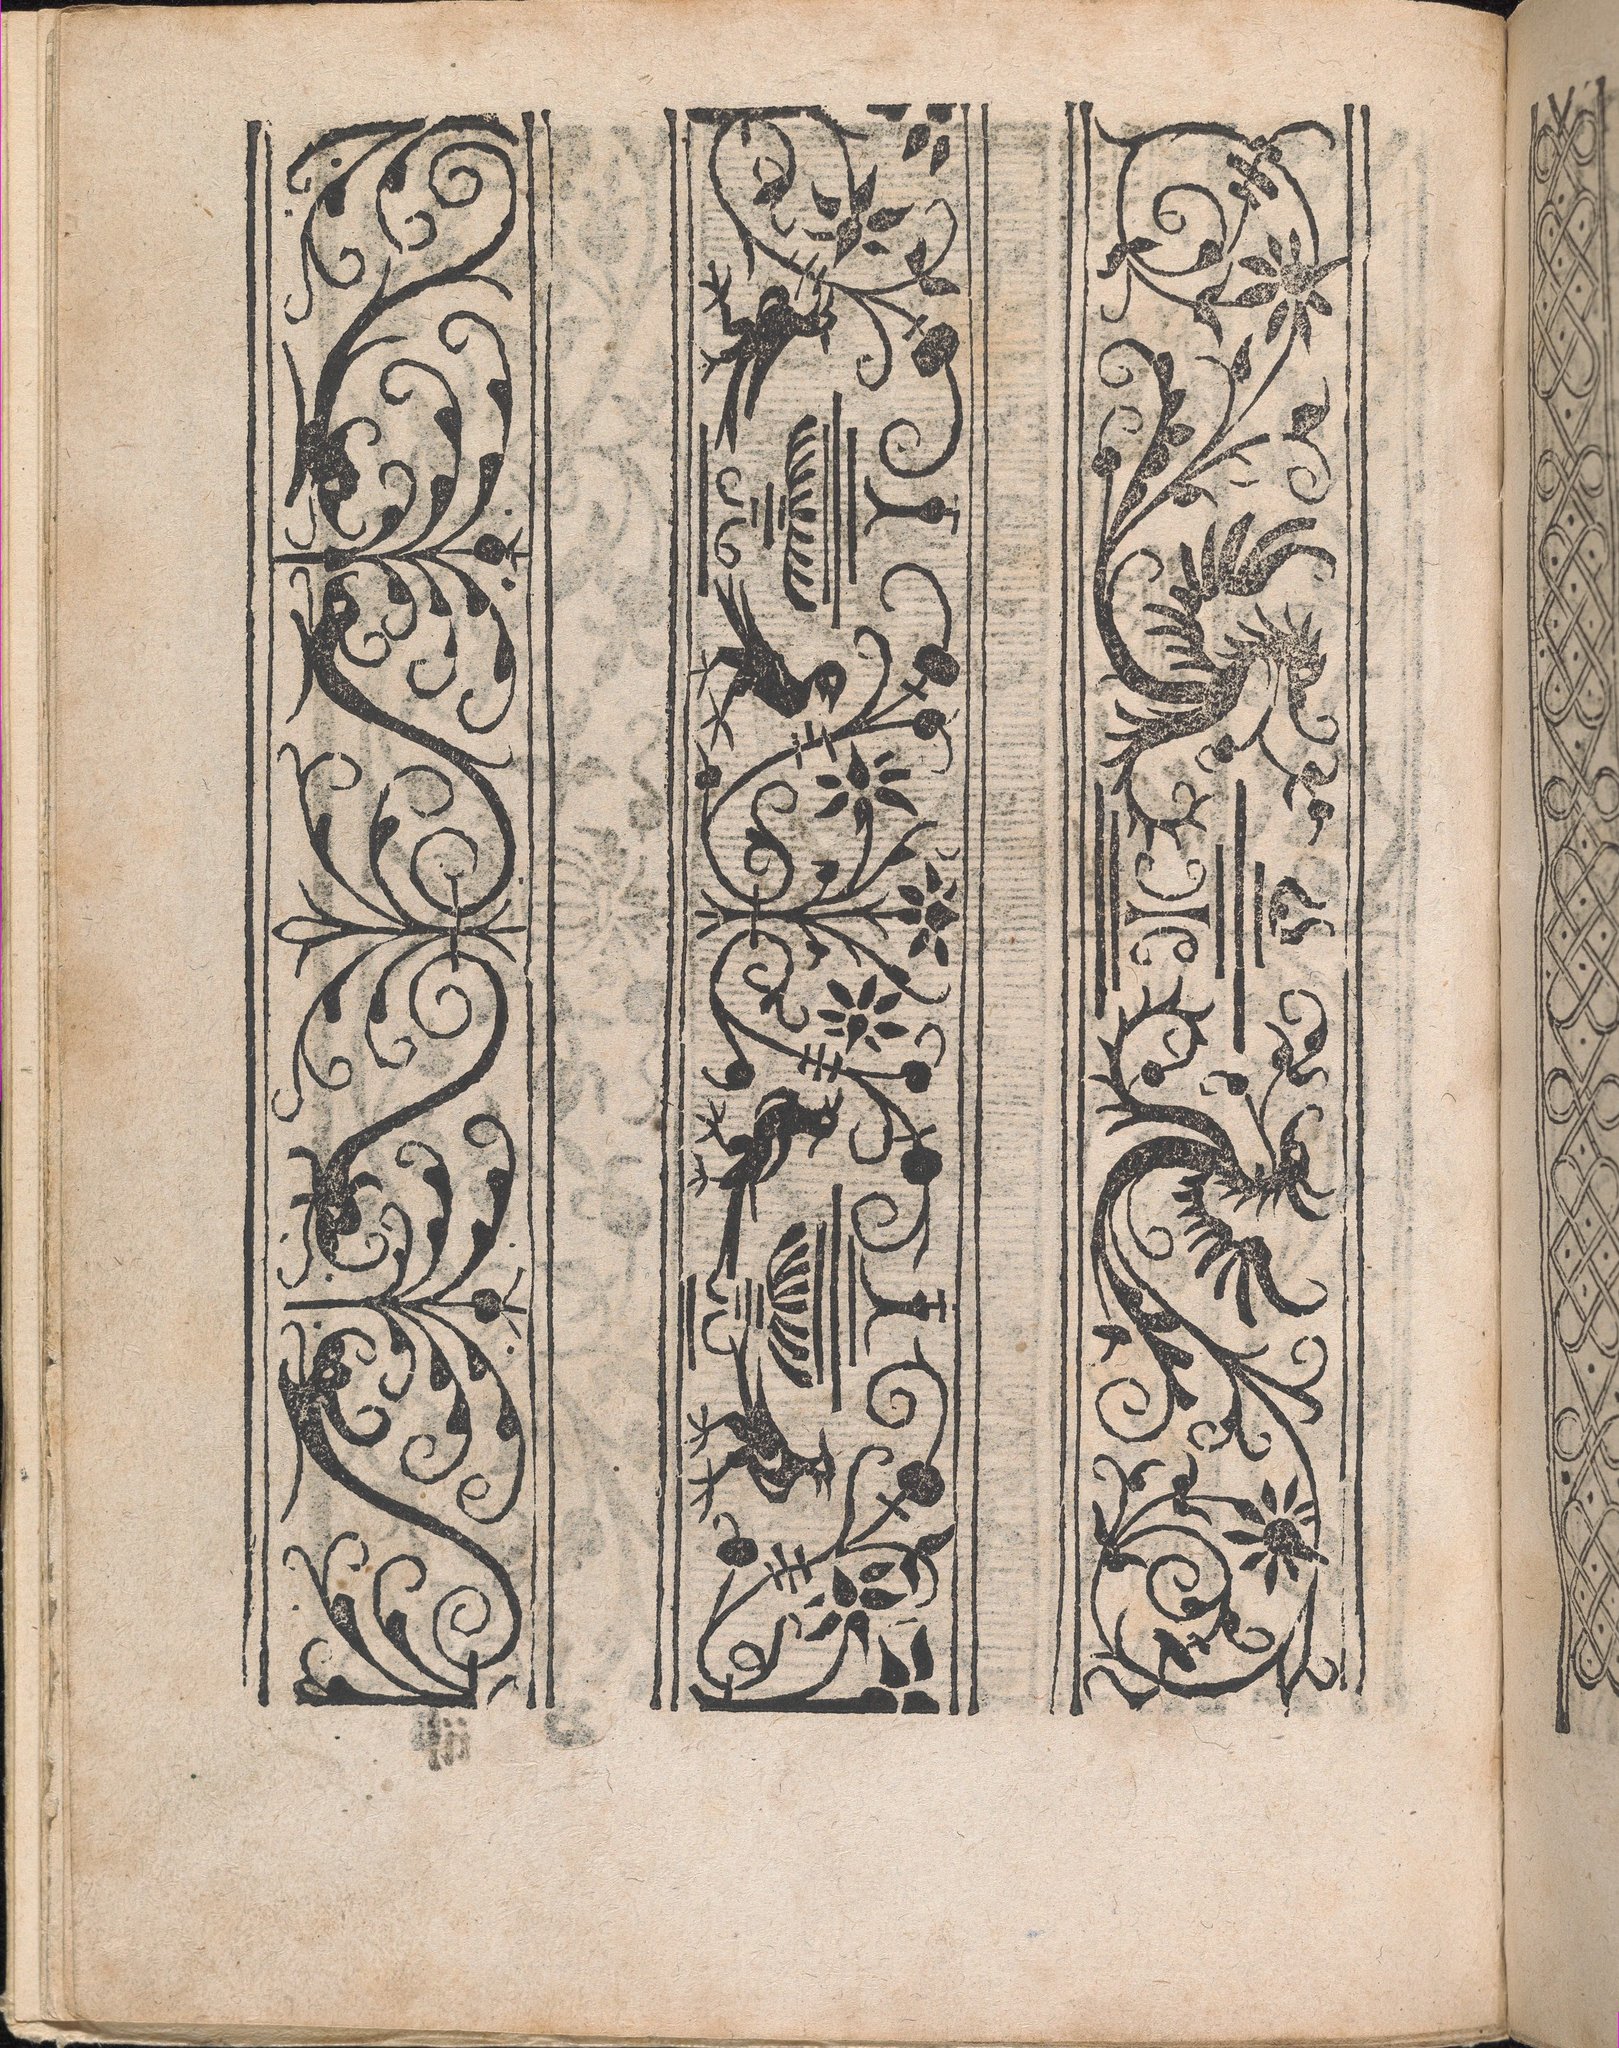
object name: book print ornament architecture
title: Modelbuch aller Art Nehens vn Stickens (Page 6v)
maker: christian egenolff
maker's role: publisher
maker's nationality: german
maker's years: 1502-1555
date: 1535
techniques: woodcut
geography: germany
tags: birds,flowers,vines